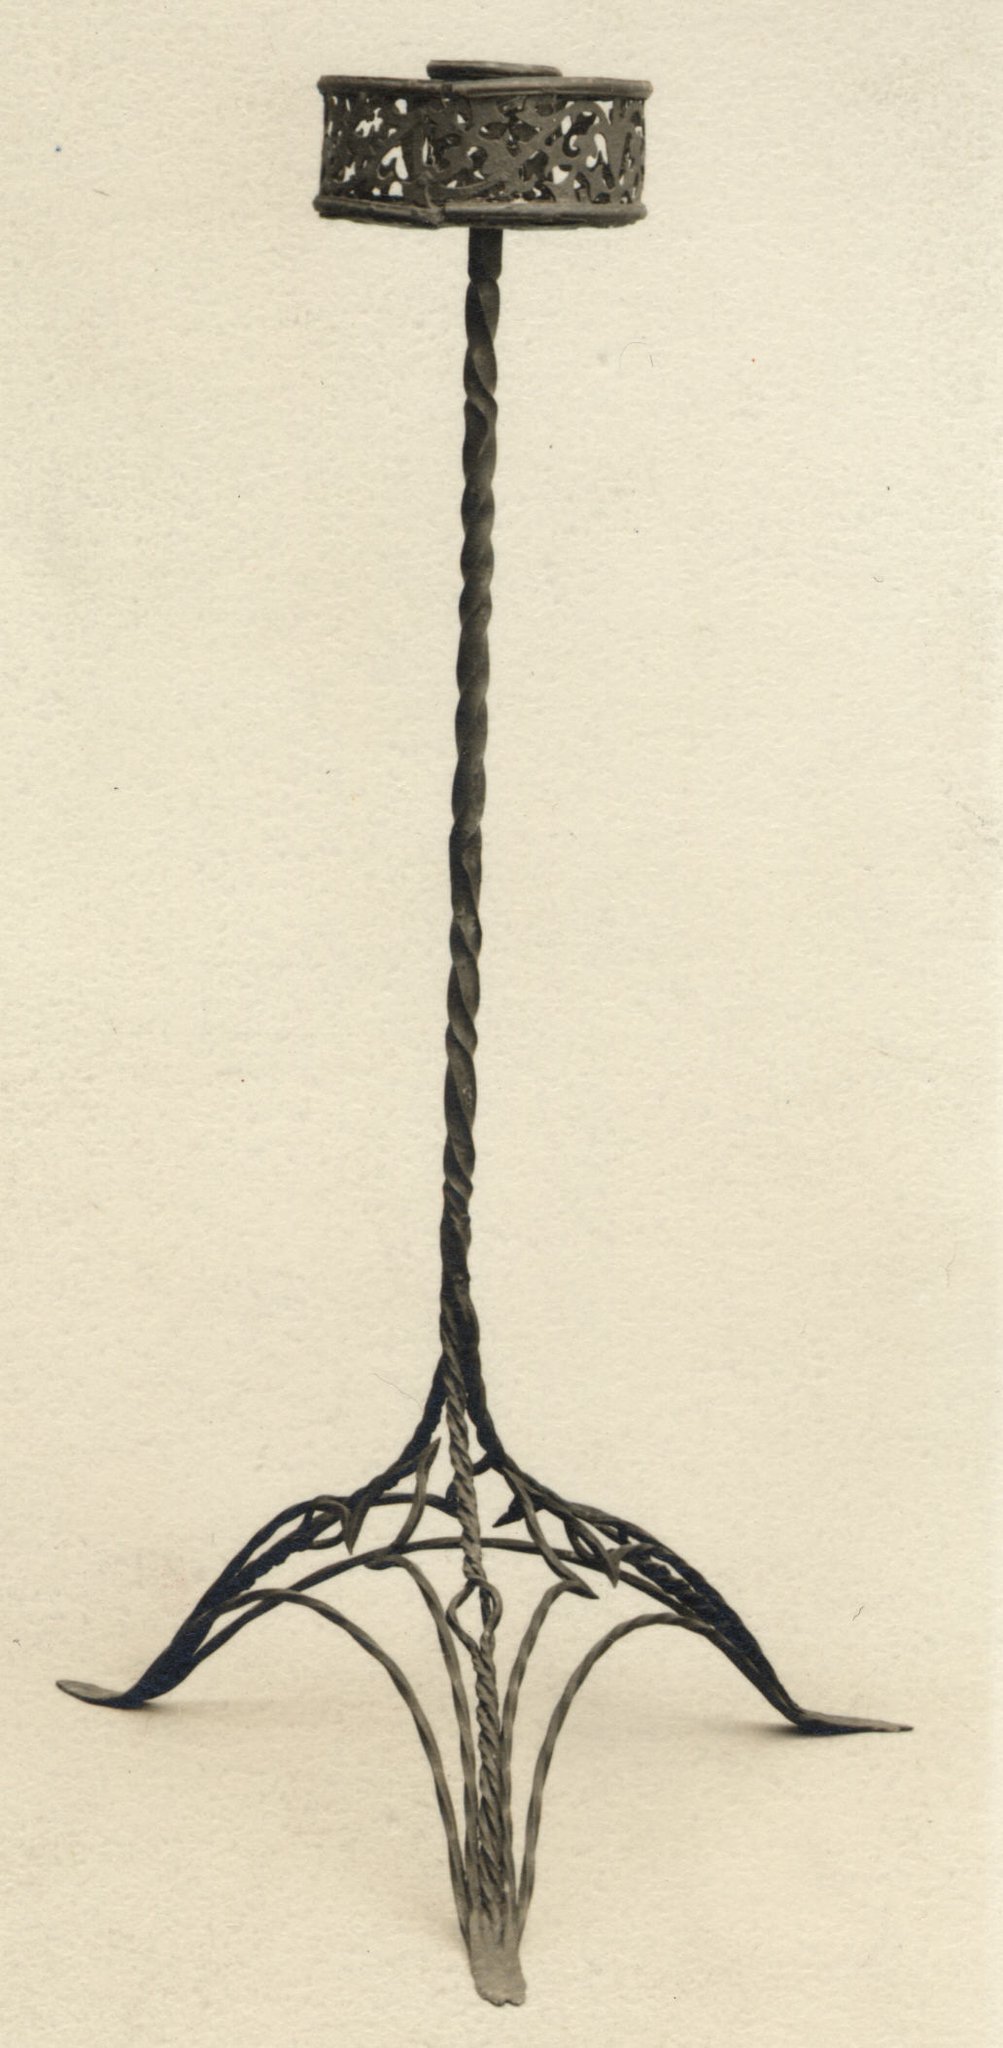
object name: candlestick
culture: european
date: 1401-1500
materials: iron